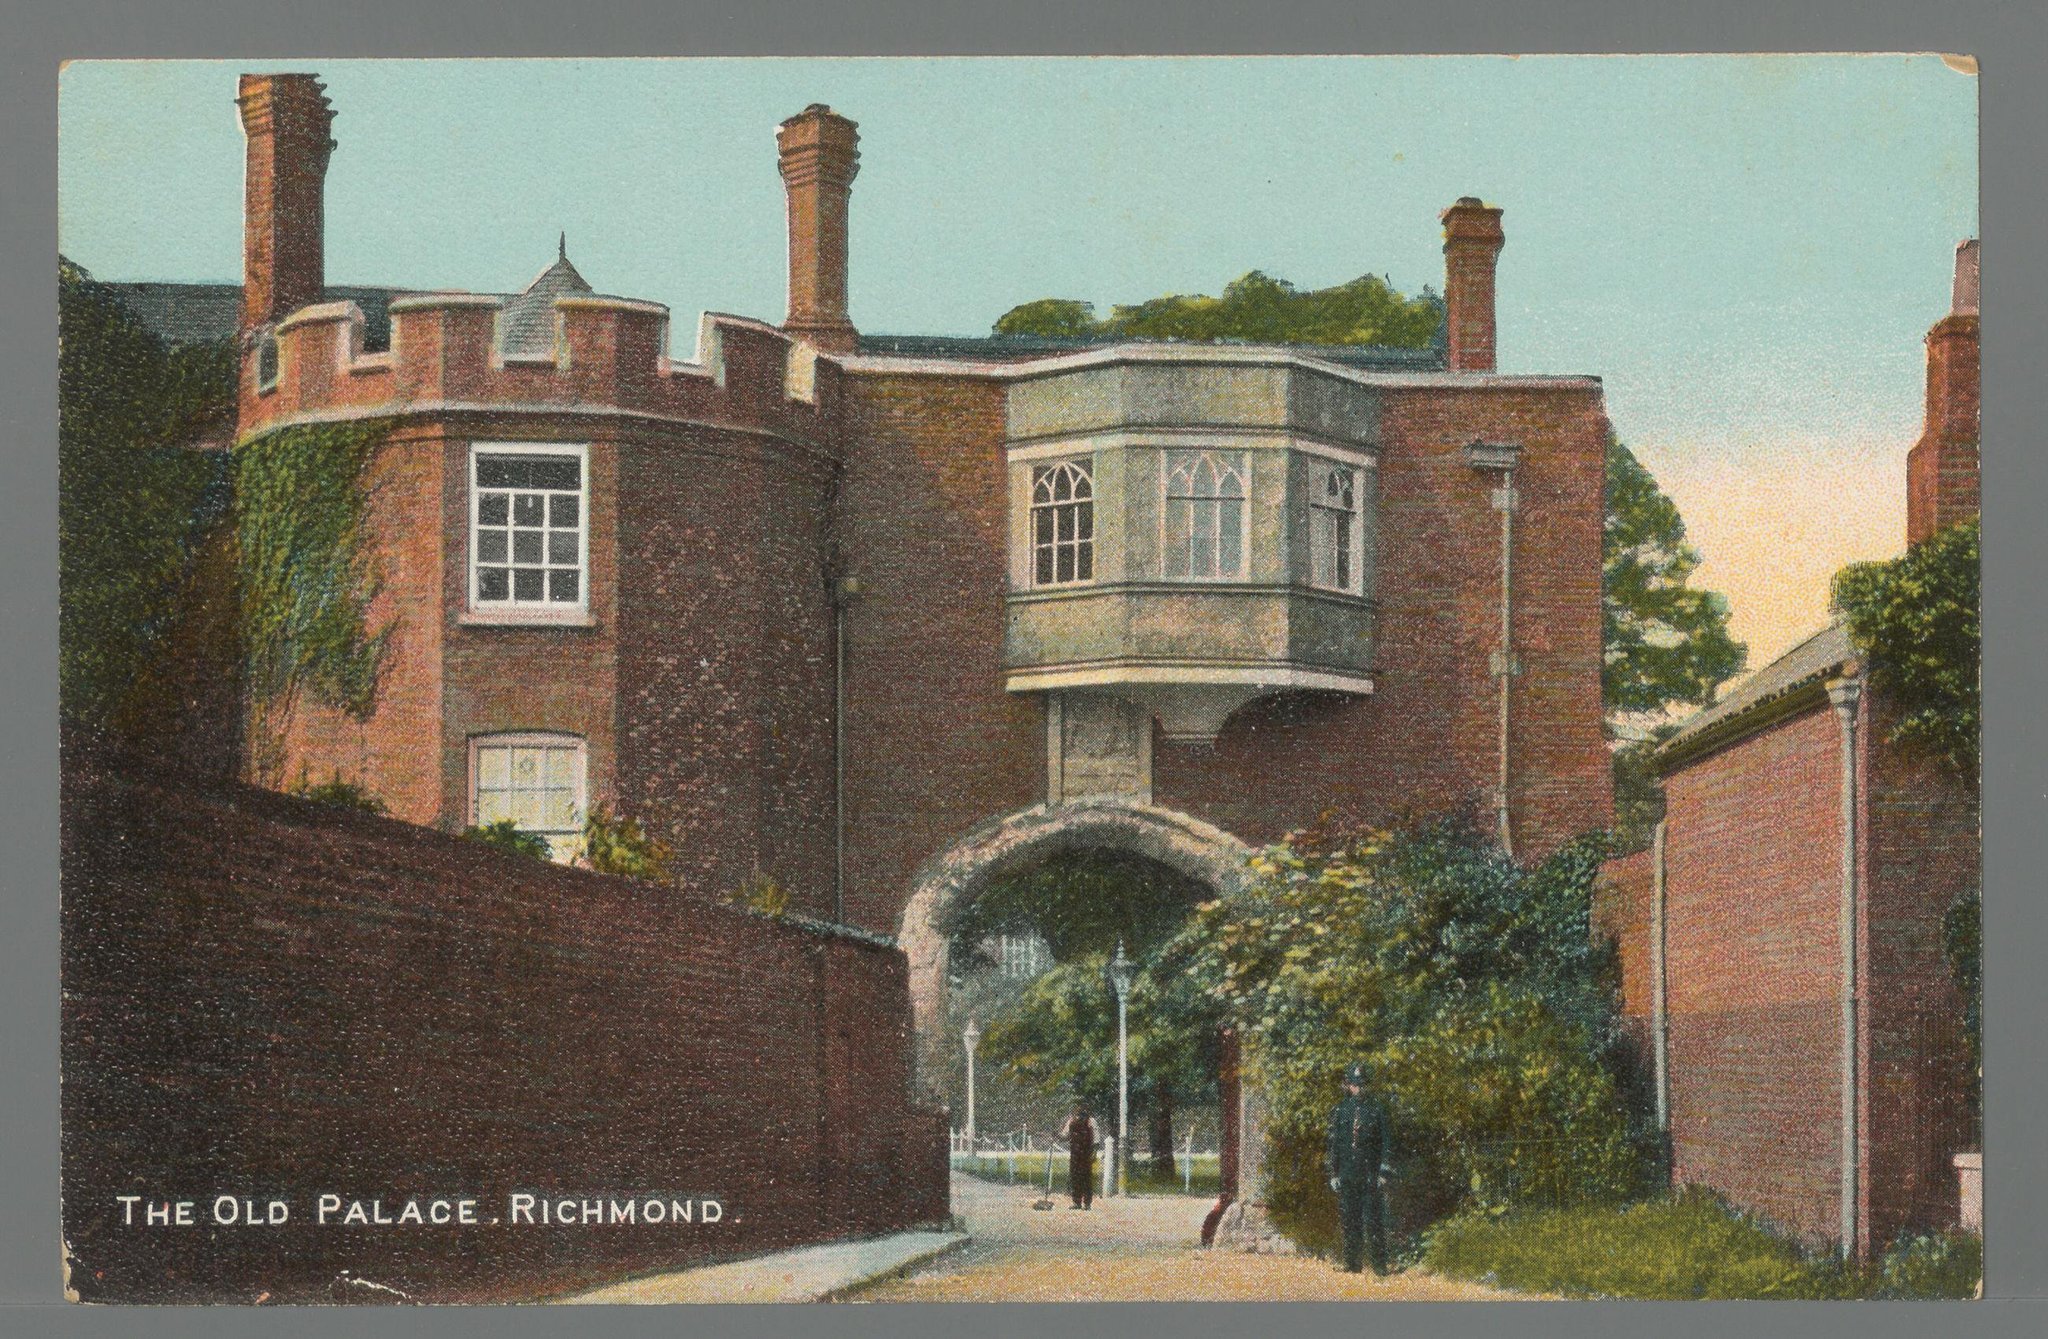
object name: photomechanical print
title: The Old Palace, Richmond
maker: Anonymous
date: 1902-1930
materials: cardboard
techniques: lithograph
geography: richmond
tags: castle, gate, entrance